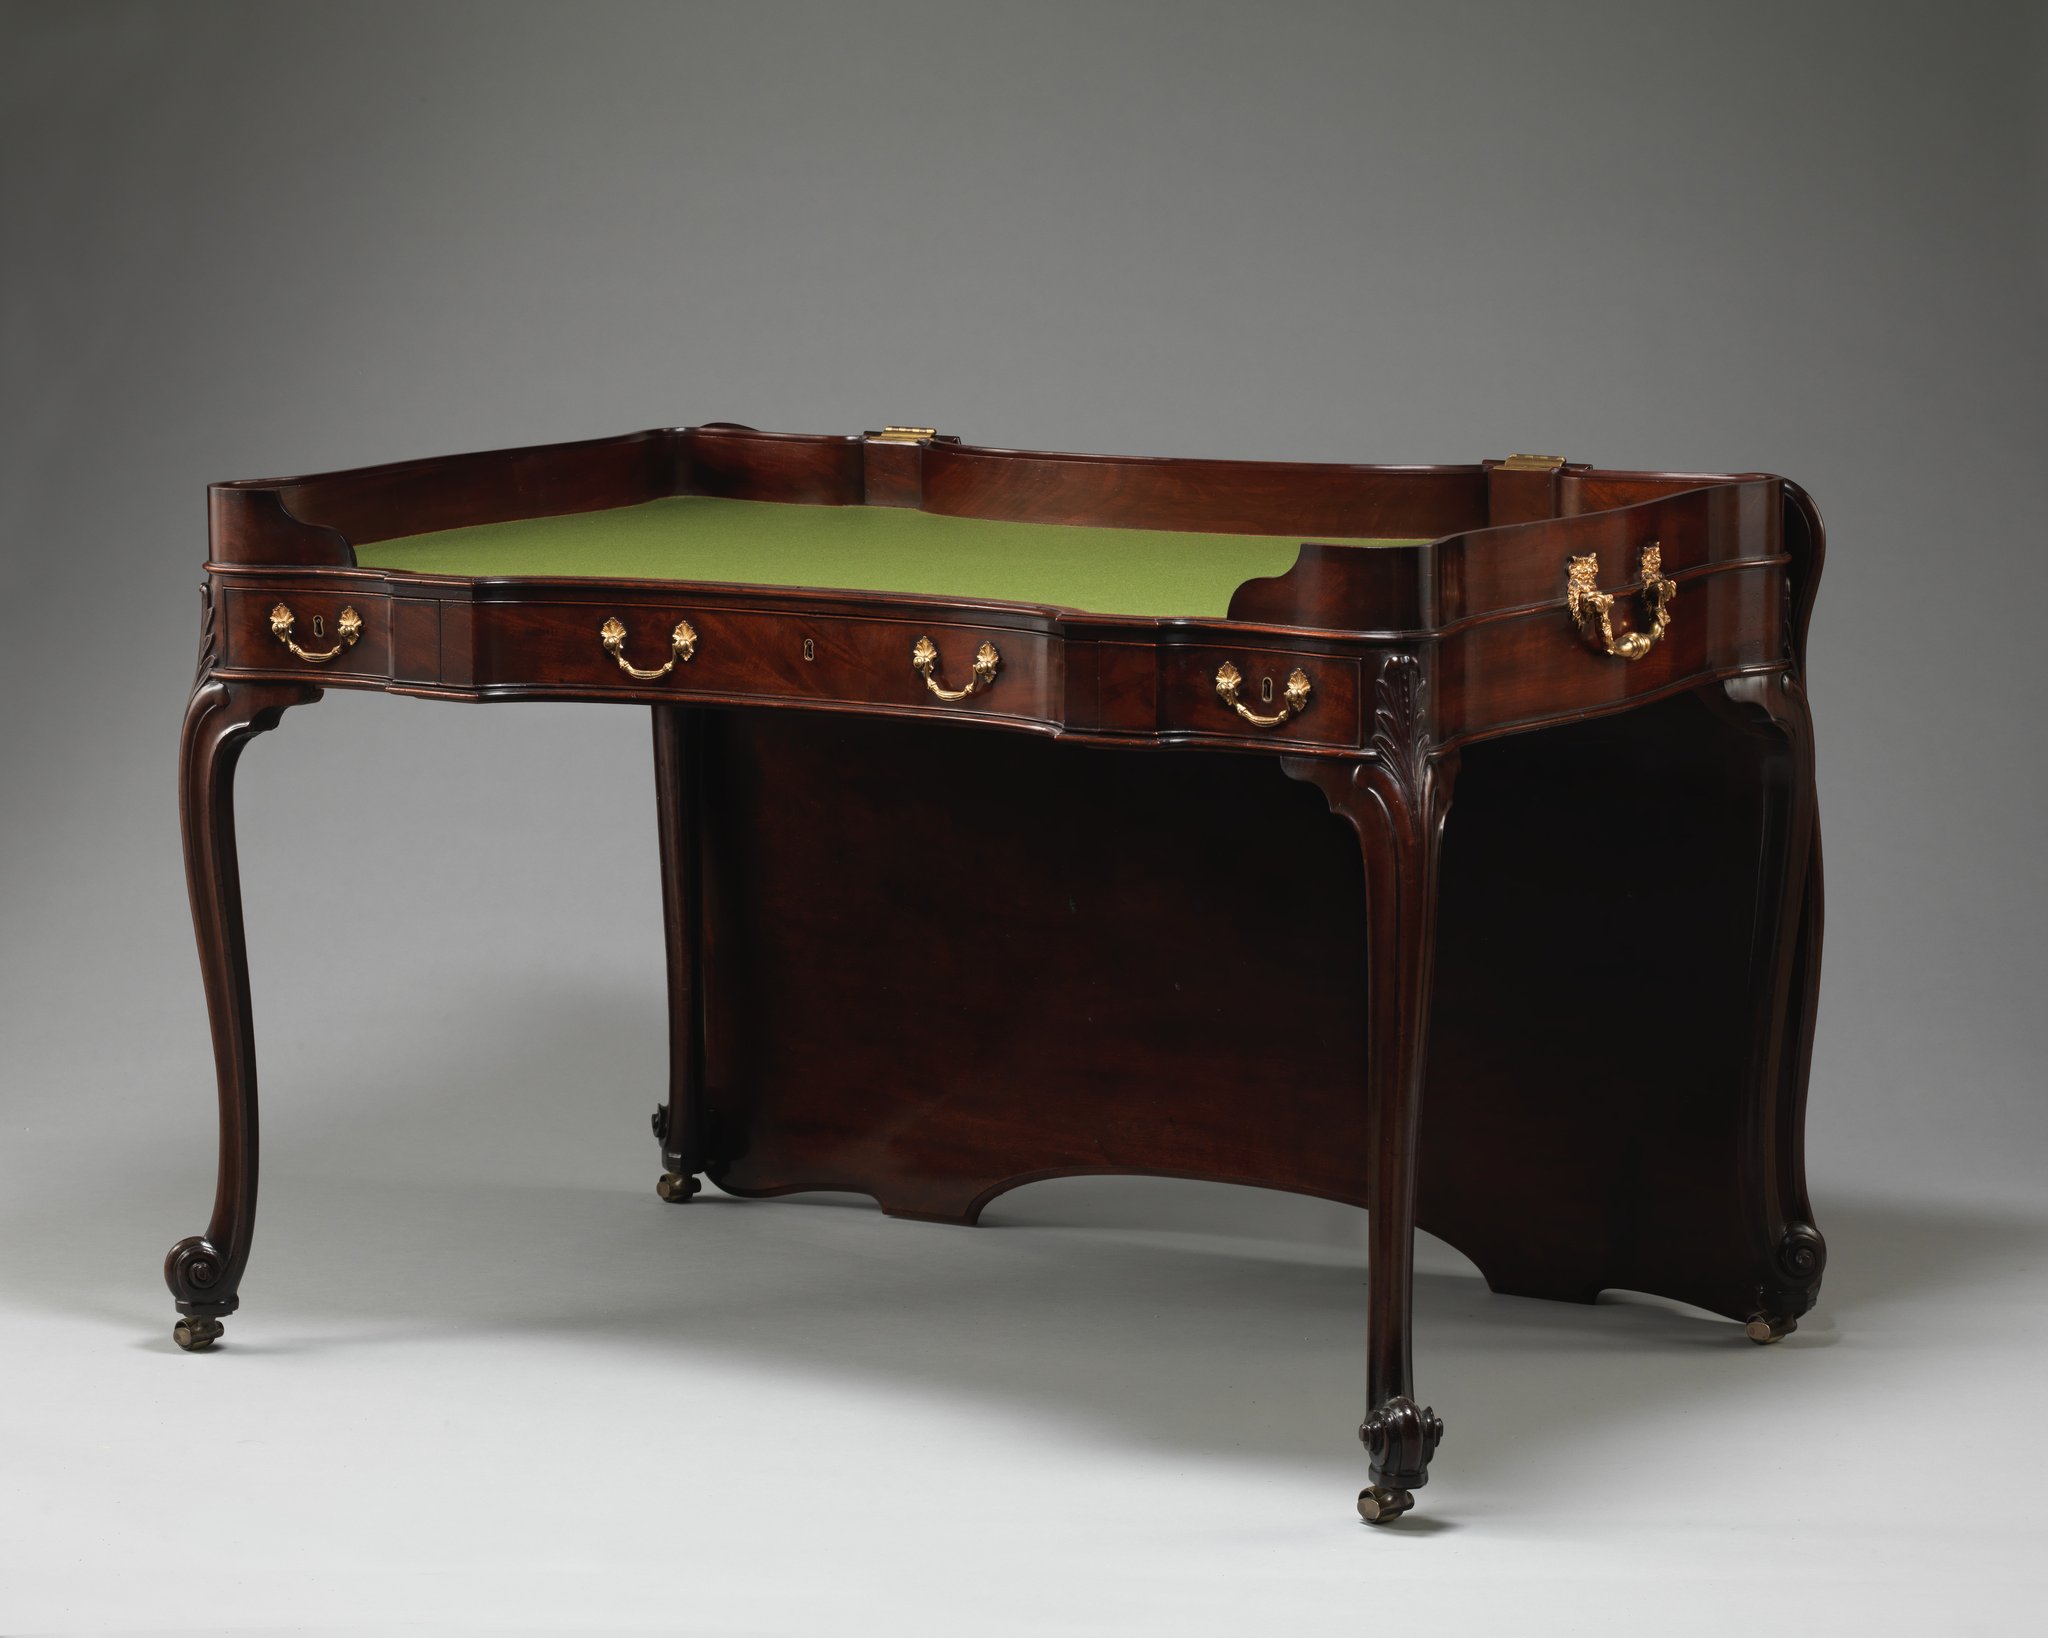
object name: writing table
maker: william vile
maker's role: maker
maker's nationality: british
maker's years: 1715-1767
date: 1761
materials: brass, wood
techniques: lacquer